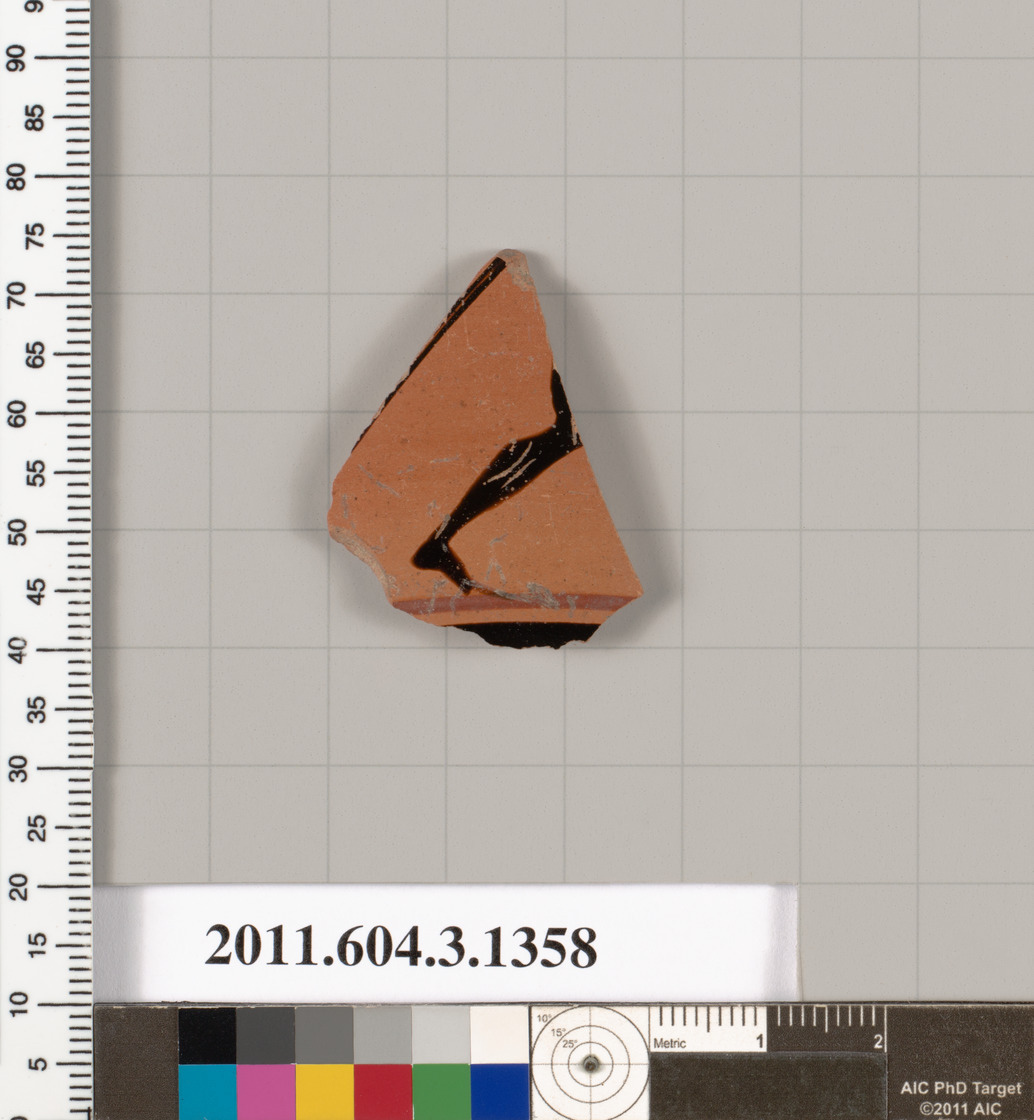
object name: skyphos fragment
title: Terracotta fragment of a skyphos (deep drinking cup)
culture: greek, attic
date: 500-468 BCE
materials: terracotta